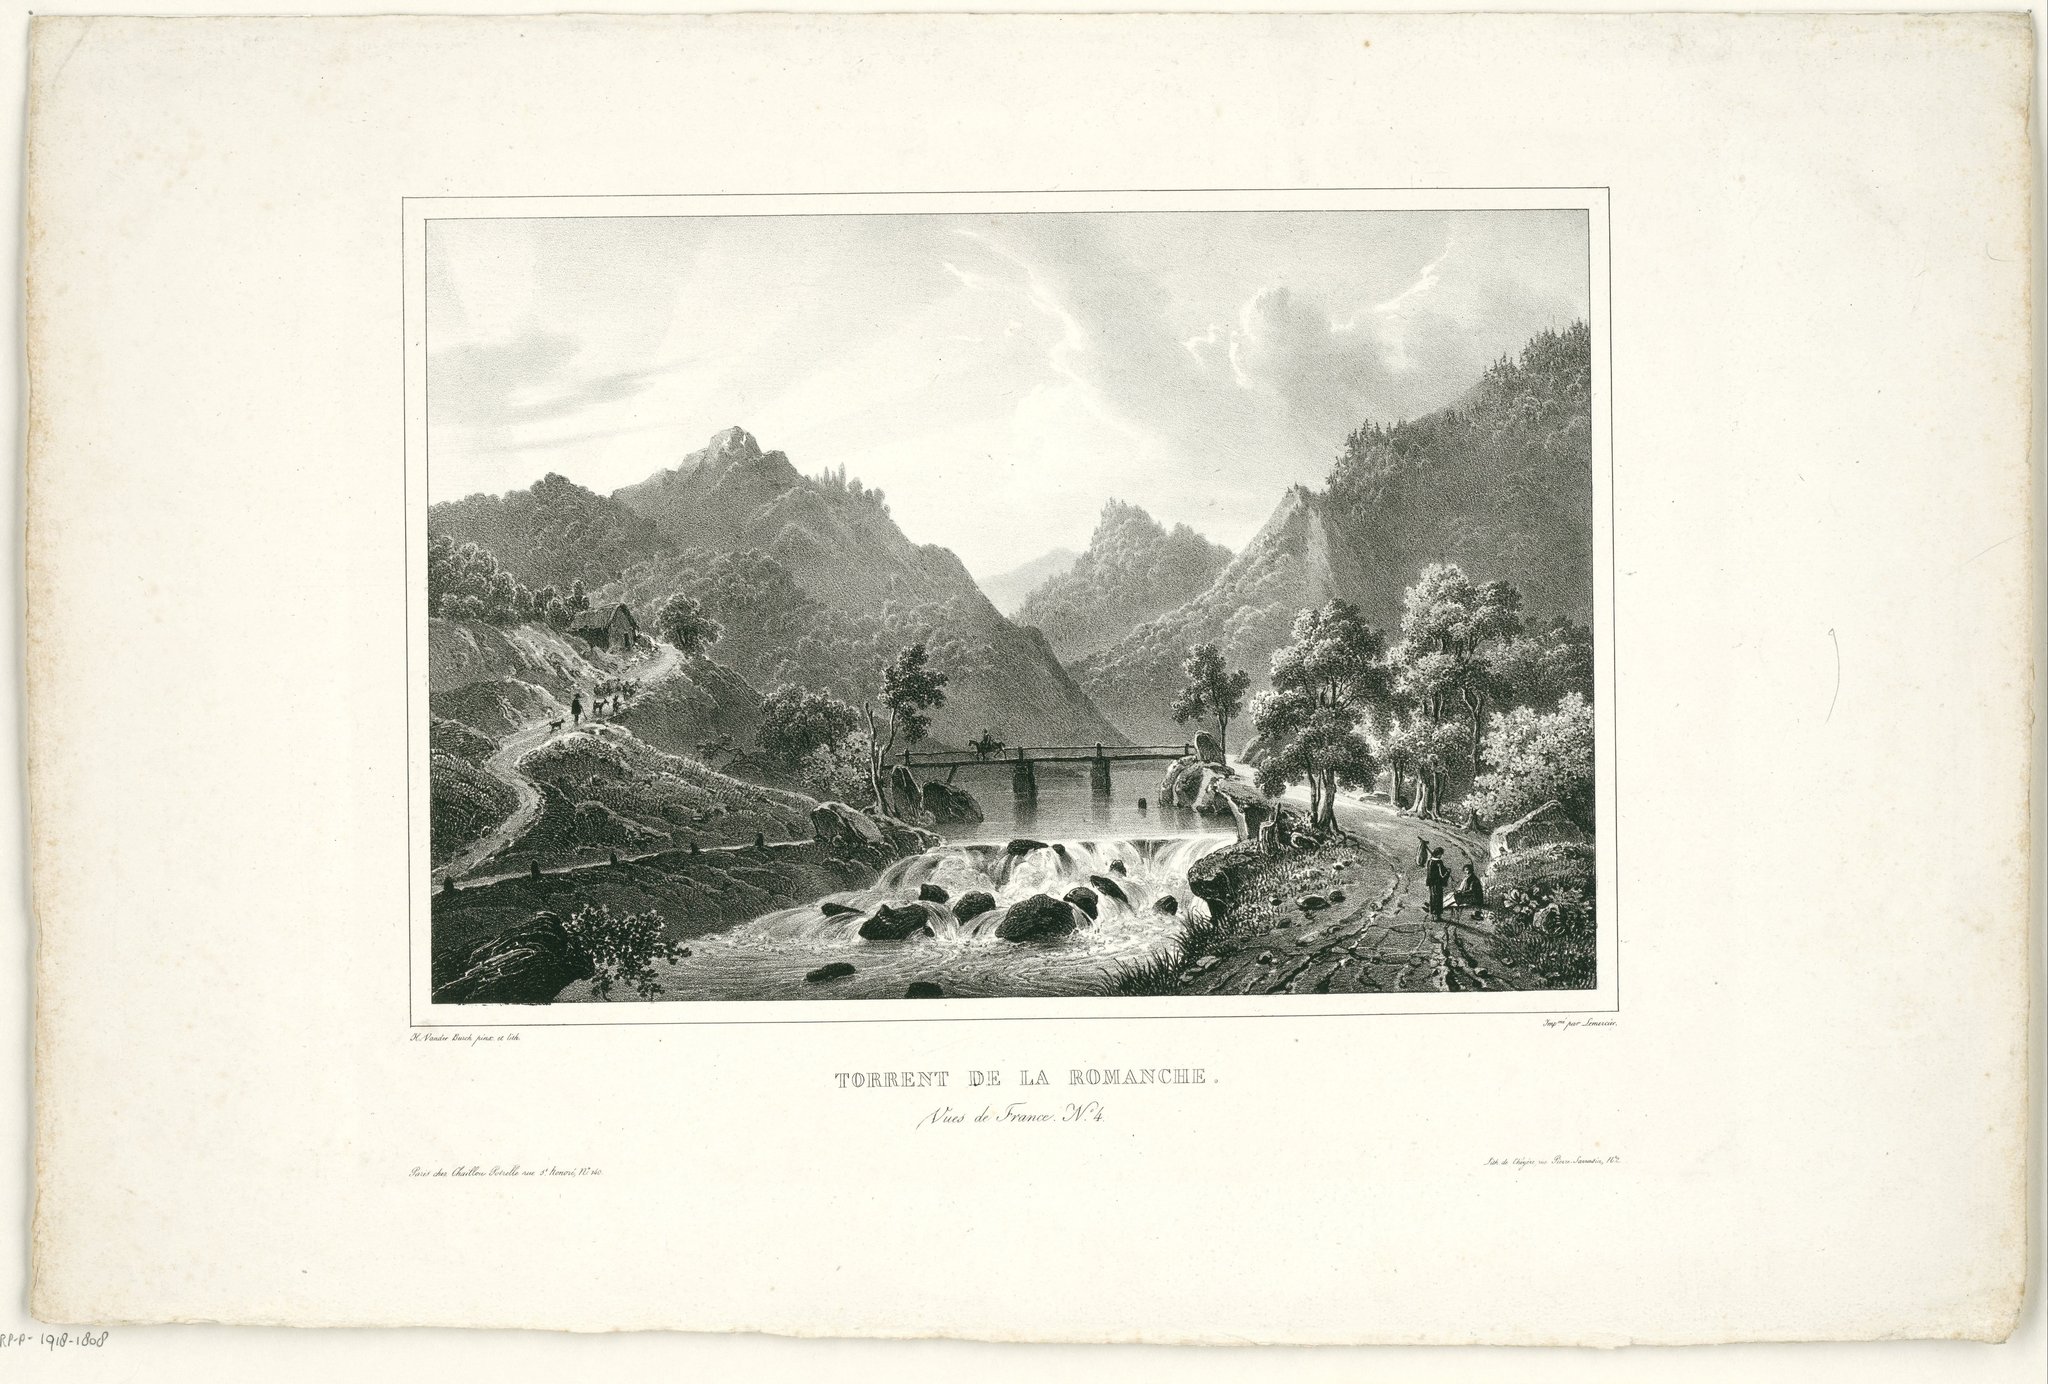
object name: print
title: Torrent de la Romanche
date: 1809-1858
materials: paper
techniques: lithograph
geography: paris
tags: rapids, herding, herdsman, herdswoman, shepherd, shepherdess, cowherd, etc., mountains (+ landscape with figures, staffage)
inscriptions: collector's mark: Lugt 2233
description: In het midden van de rivier zorgen rotsblokken en hoogteverschil voor een stroomversnelling in het water. Verderop ligt een brug over het water met daarop een ruiter te paard. Links van de rivier loopt een landweg de bergen in naar een klein huis. Daar loopt een herder met zijn kudde. Op de weg rechts van de rivier twee rustende wandelaars. De prent maakt deel uit van een serie: Vues de France, nummer 3.